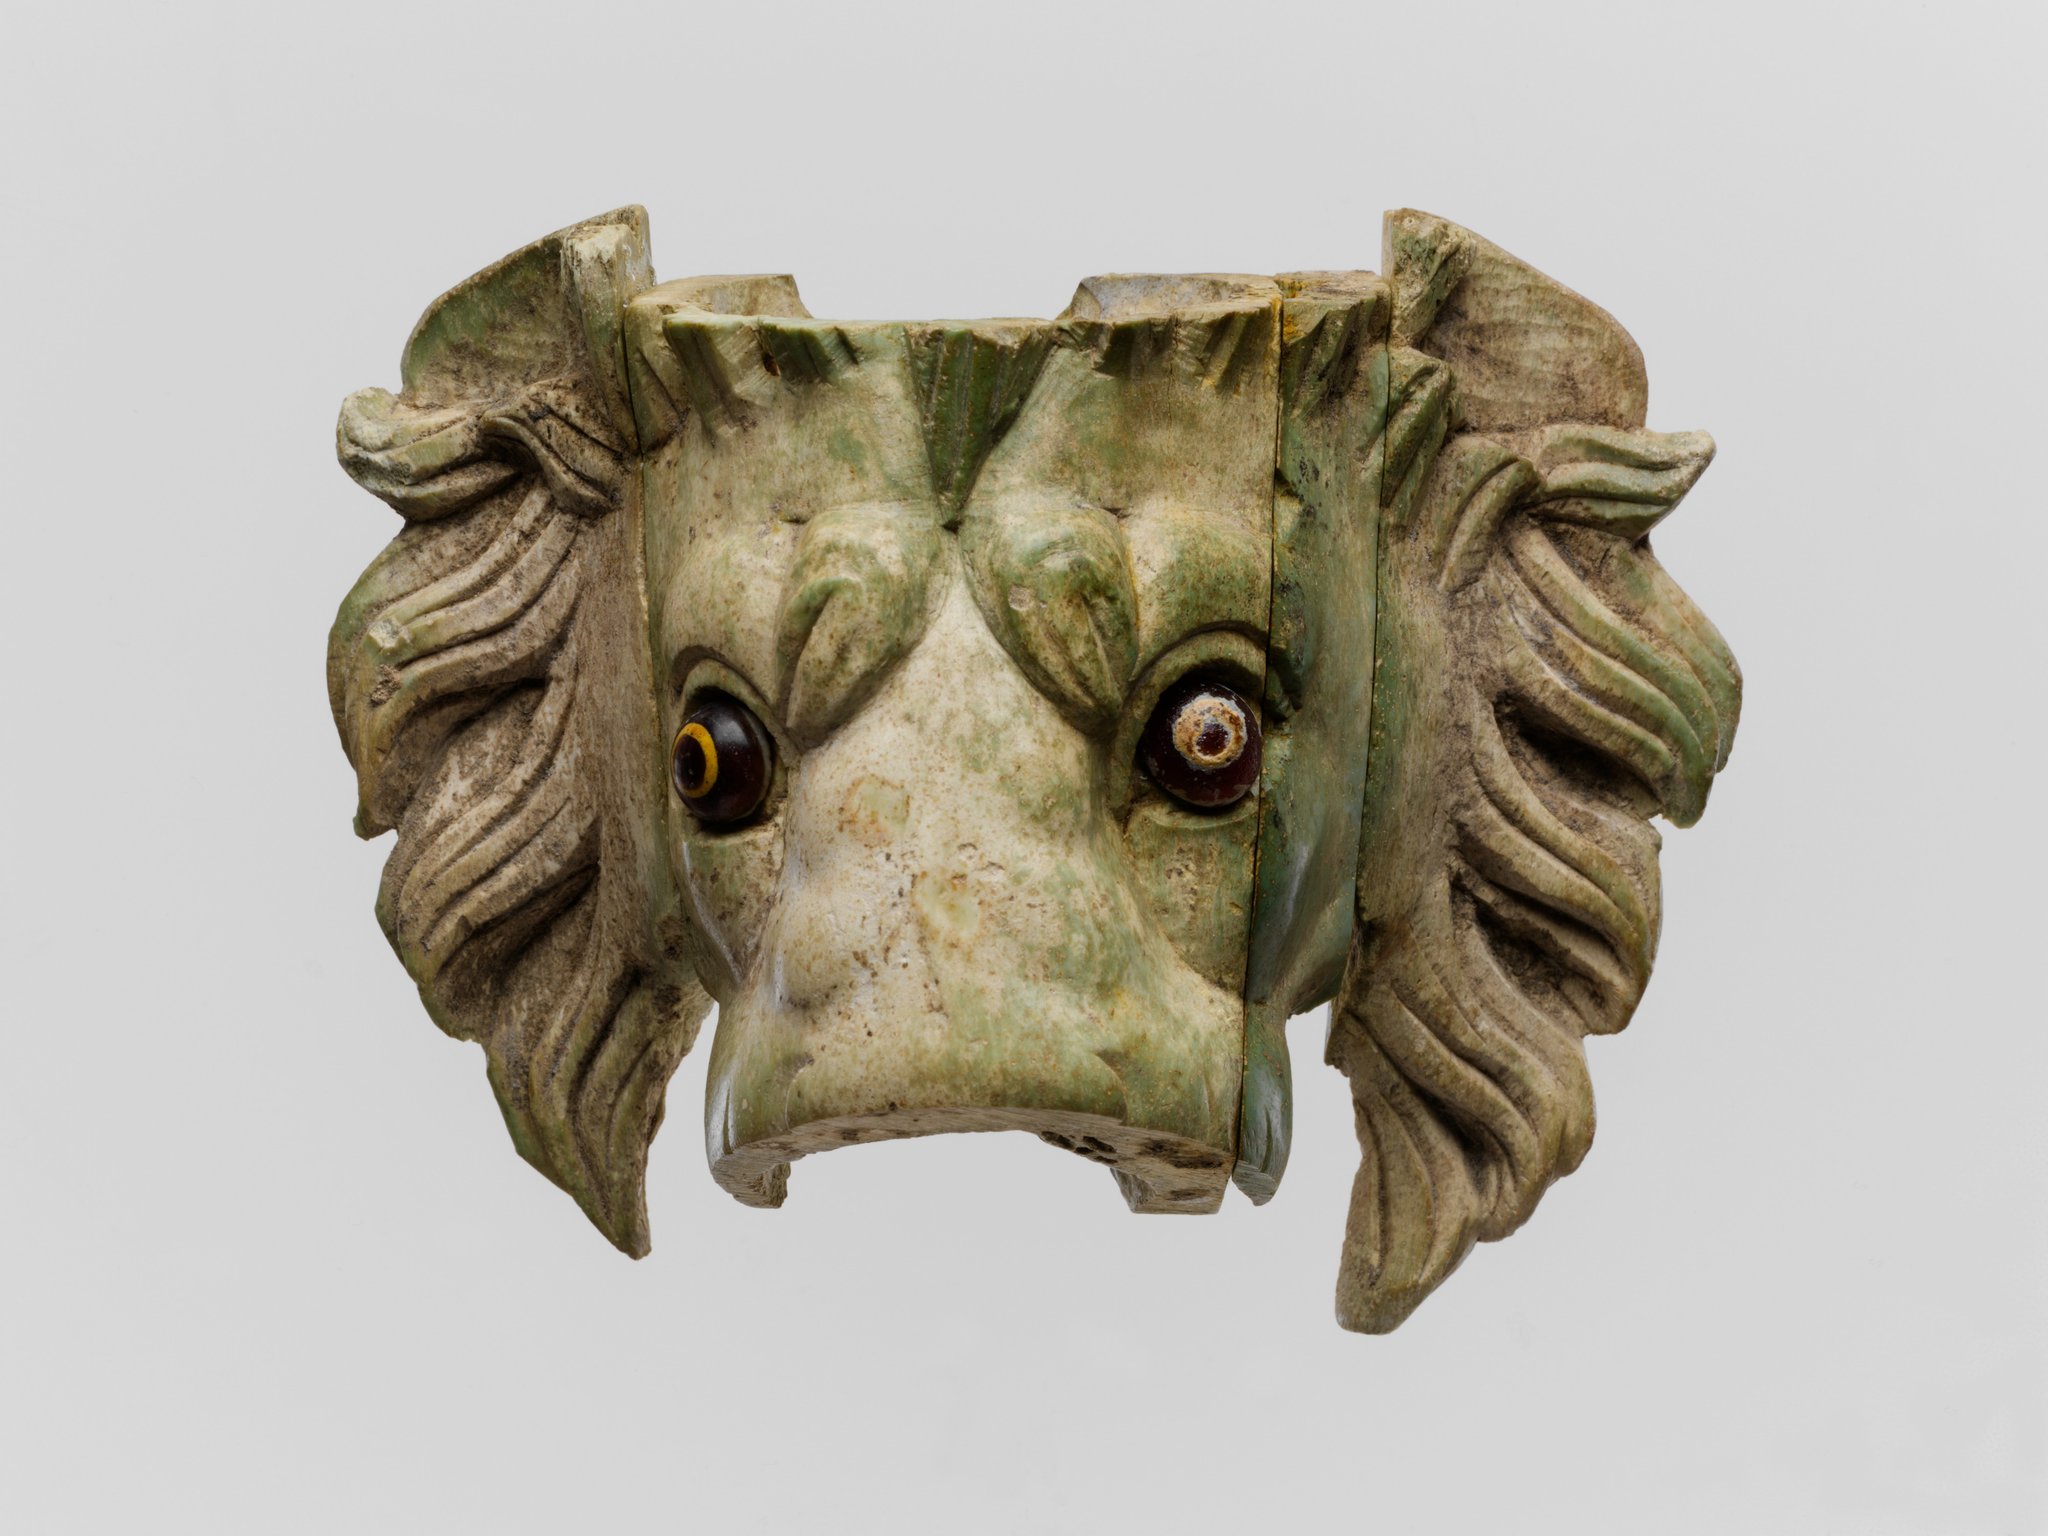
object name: protome, lion's head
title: Bone lion's head protome with glass eyes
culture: roman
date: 1-100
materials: bone, glass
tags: lions